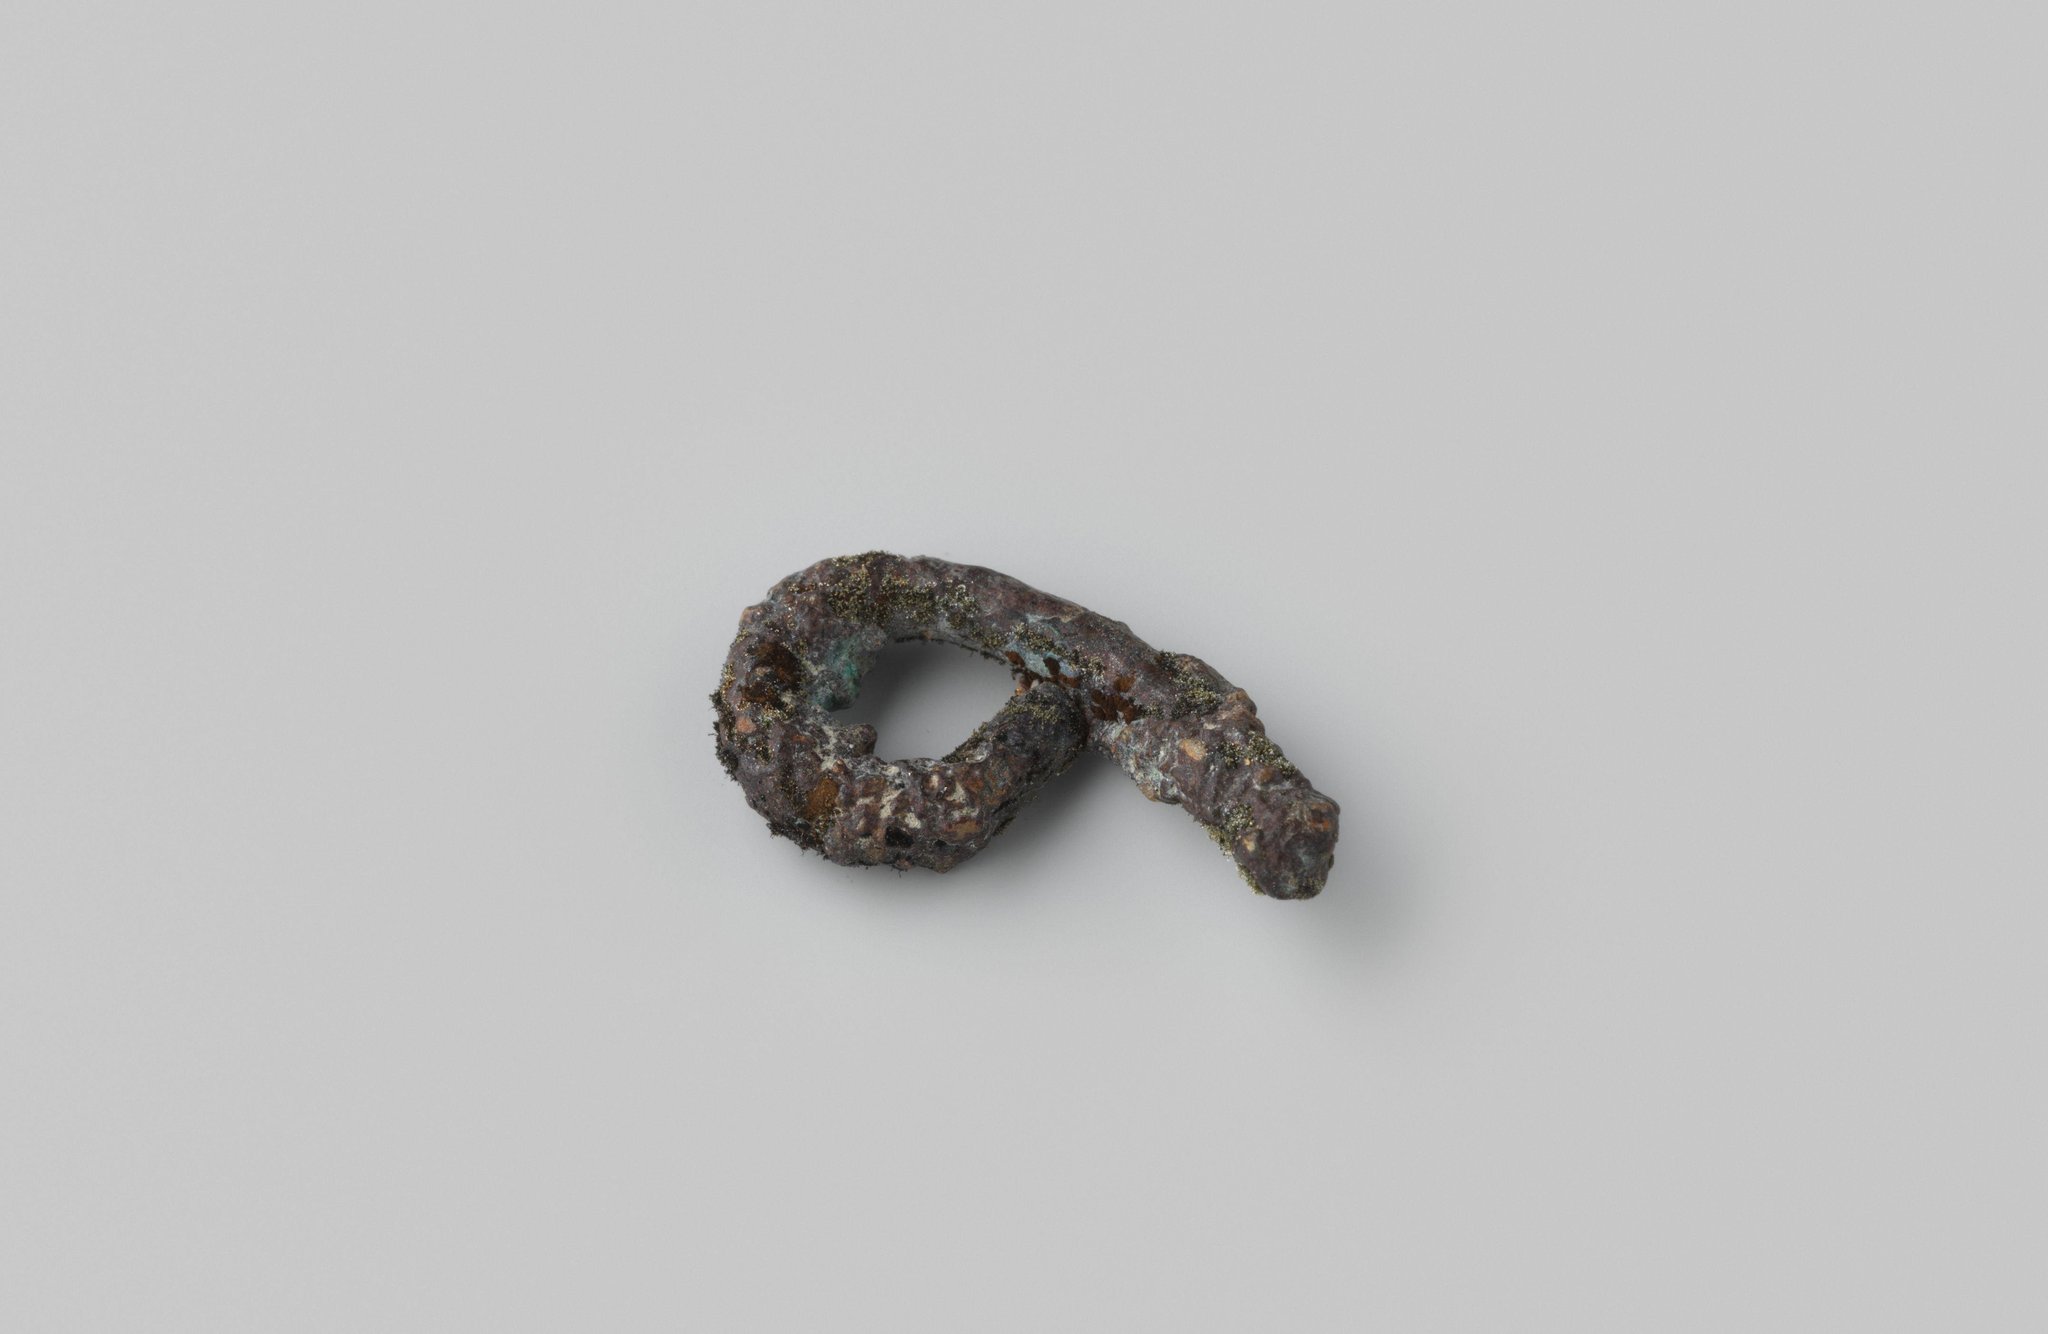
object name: screw eye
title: Schroefoog afkomstig uit het wrak van de Oost-Indiëvaarder Hollandia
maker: Anonymous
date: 1700-1743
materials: copper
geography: netherlands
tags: verenigde oostindische compagnie, hollandia (schip)